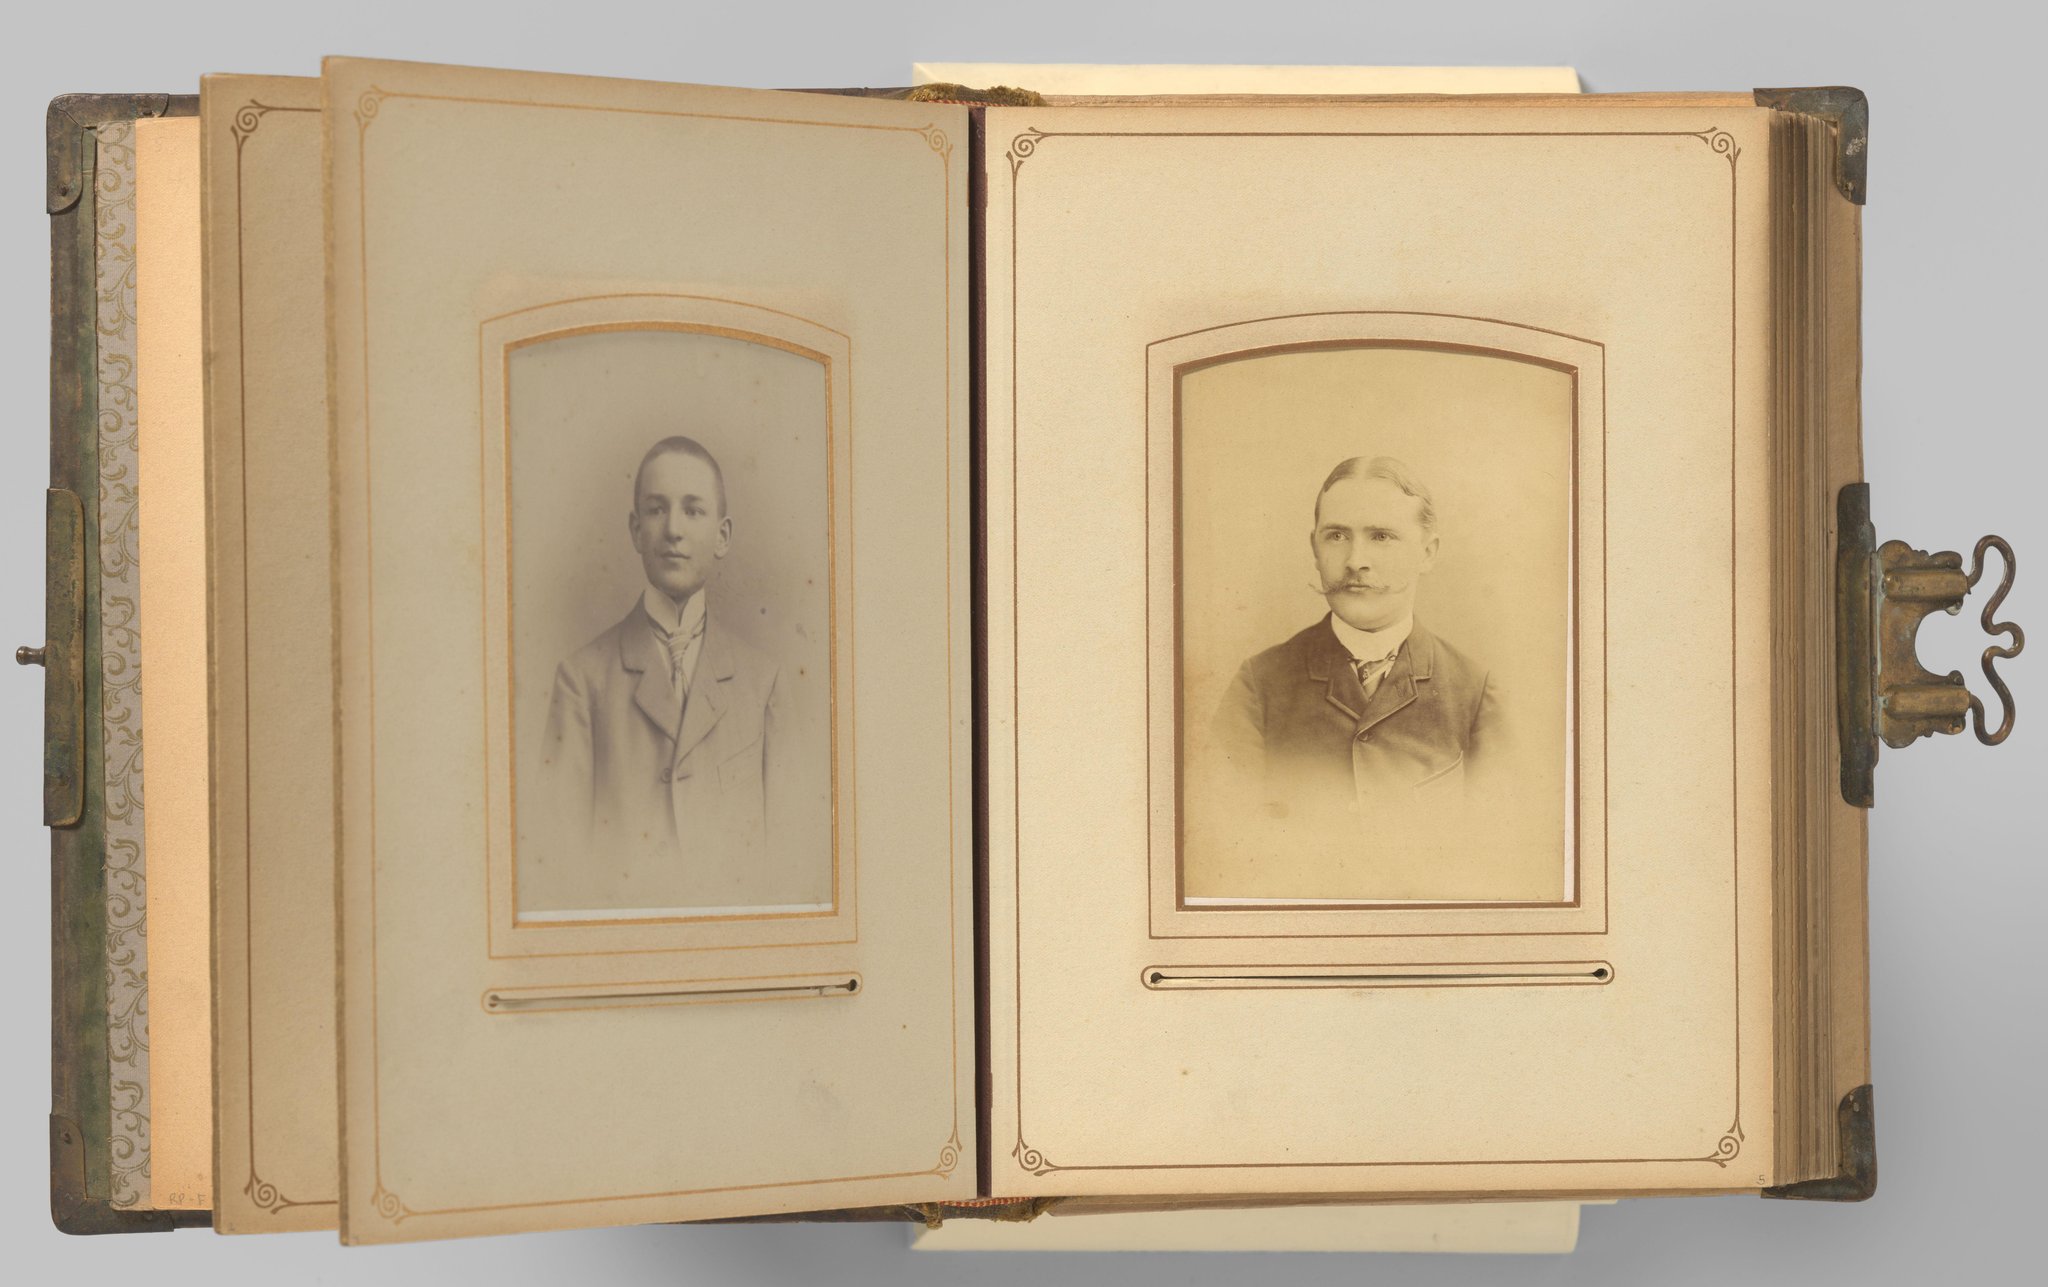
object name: photograph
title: Portret van een man met snor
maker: ernst wolffram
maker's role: fotograaf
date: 1860-1900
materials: cardboard, photographic support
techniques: albumen print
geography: bremen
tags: moustache, historical persons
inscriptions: inscription: ‘Wolffram Photograph/ Bremen/ 14. Fedelhören 14,/ beim Bischofsthor.’